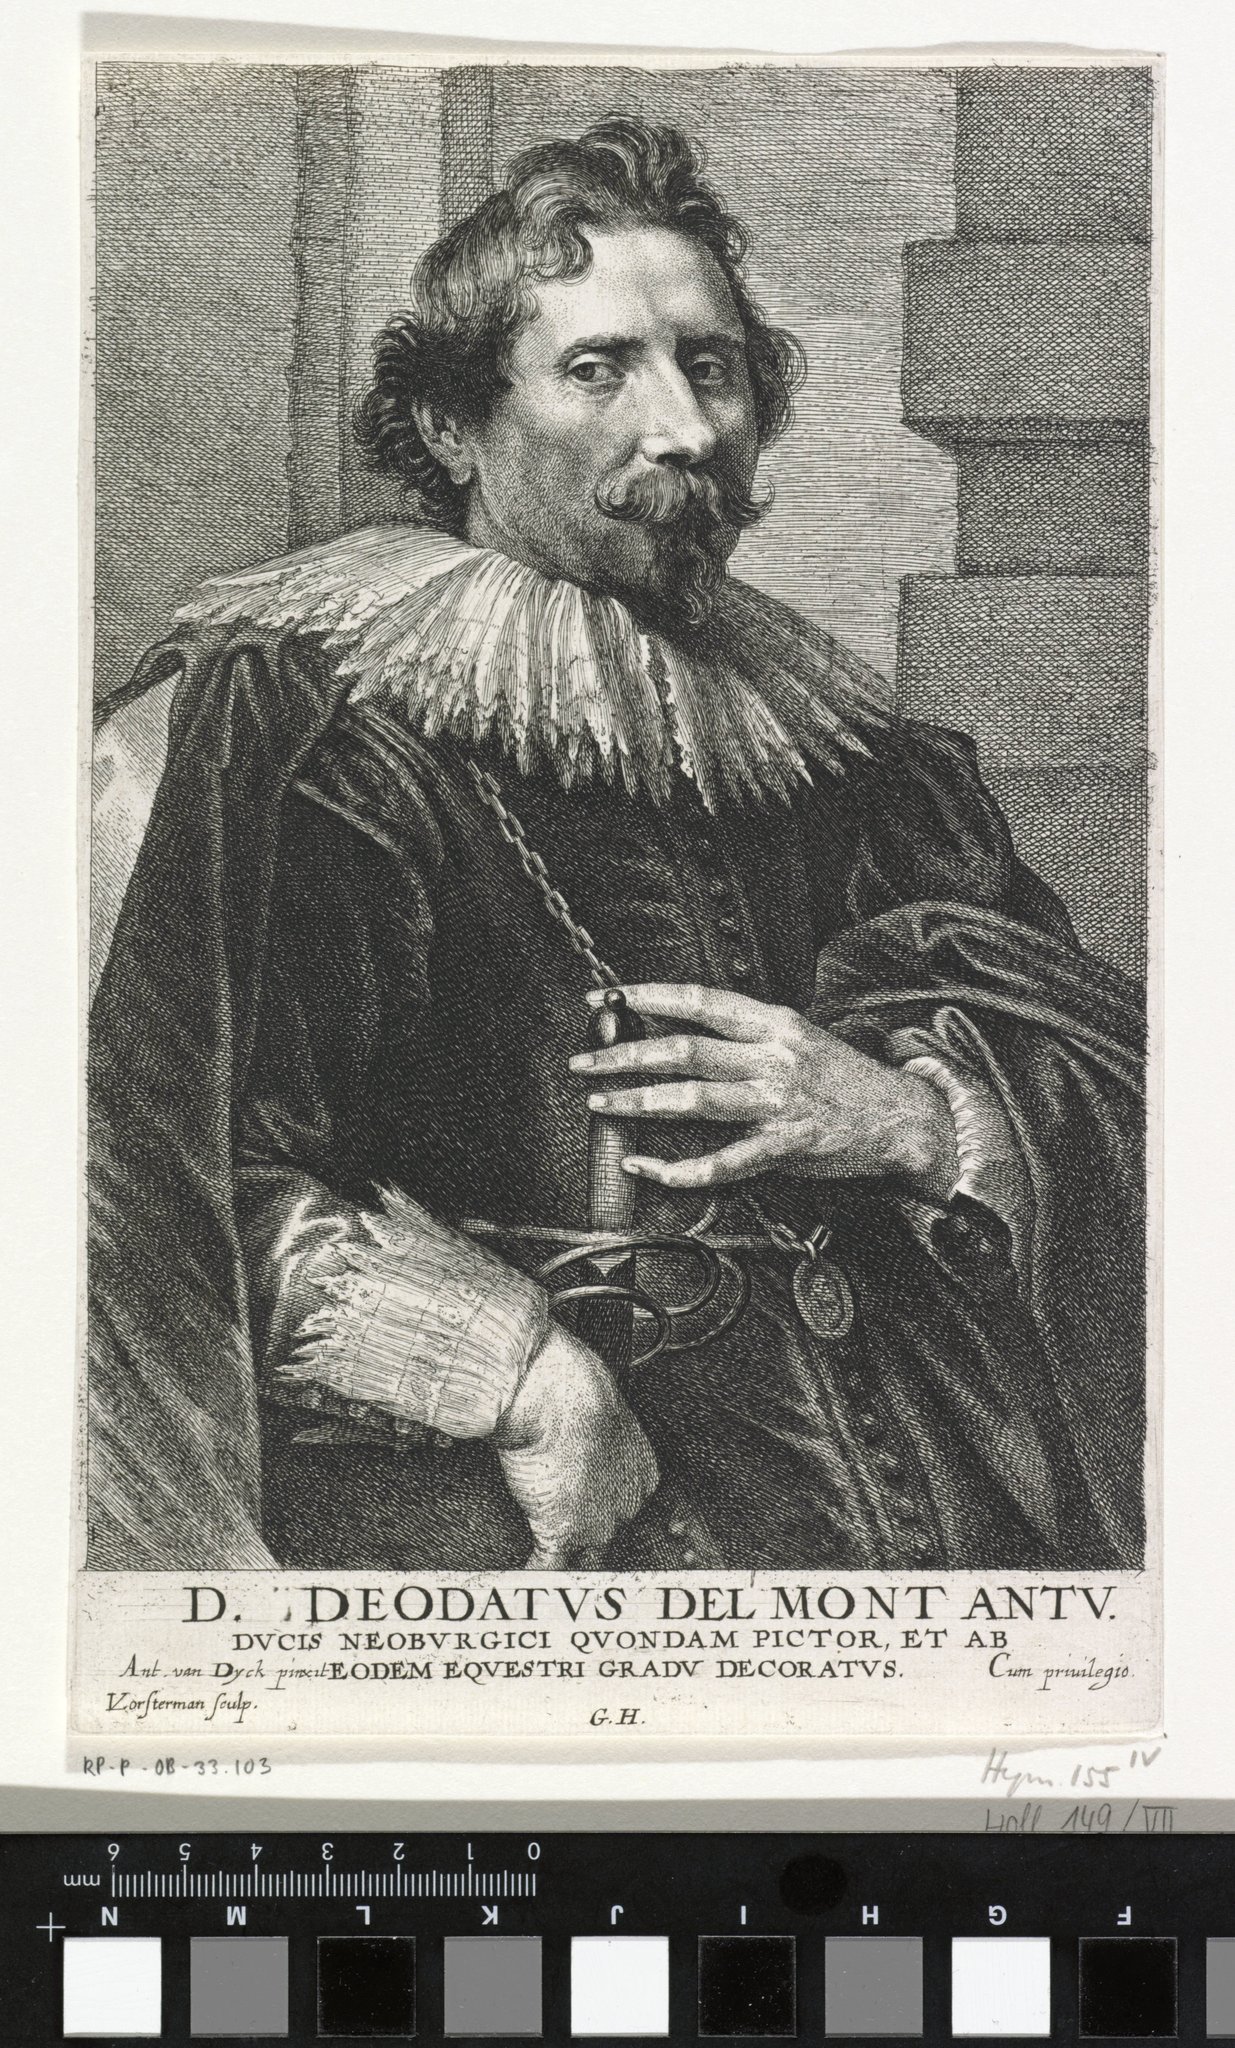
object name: print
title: Portret van Deodat van der Mont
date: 1645-1646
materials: paper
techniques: engraving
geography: antwerp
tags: painter, deodat van der mont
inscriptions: collector's mark: Lugt 240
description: Prent gebruikt voor: Icones principum, virorum doctorum, pictorum, chalcographorum, statuariorum nec non amatorum pictoriae artis numero centum ab Ant. van Dyck ad vivum expressae ejusque sumptibus aeri incisae. Antwerpen: Gillis Hendricx, [1645-1646].